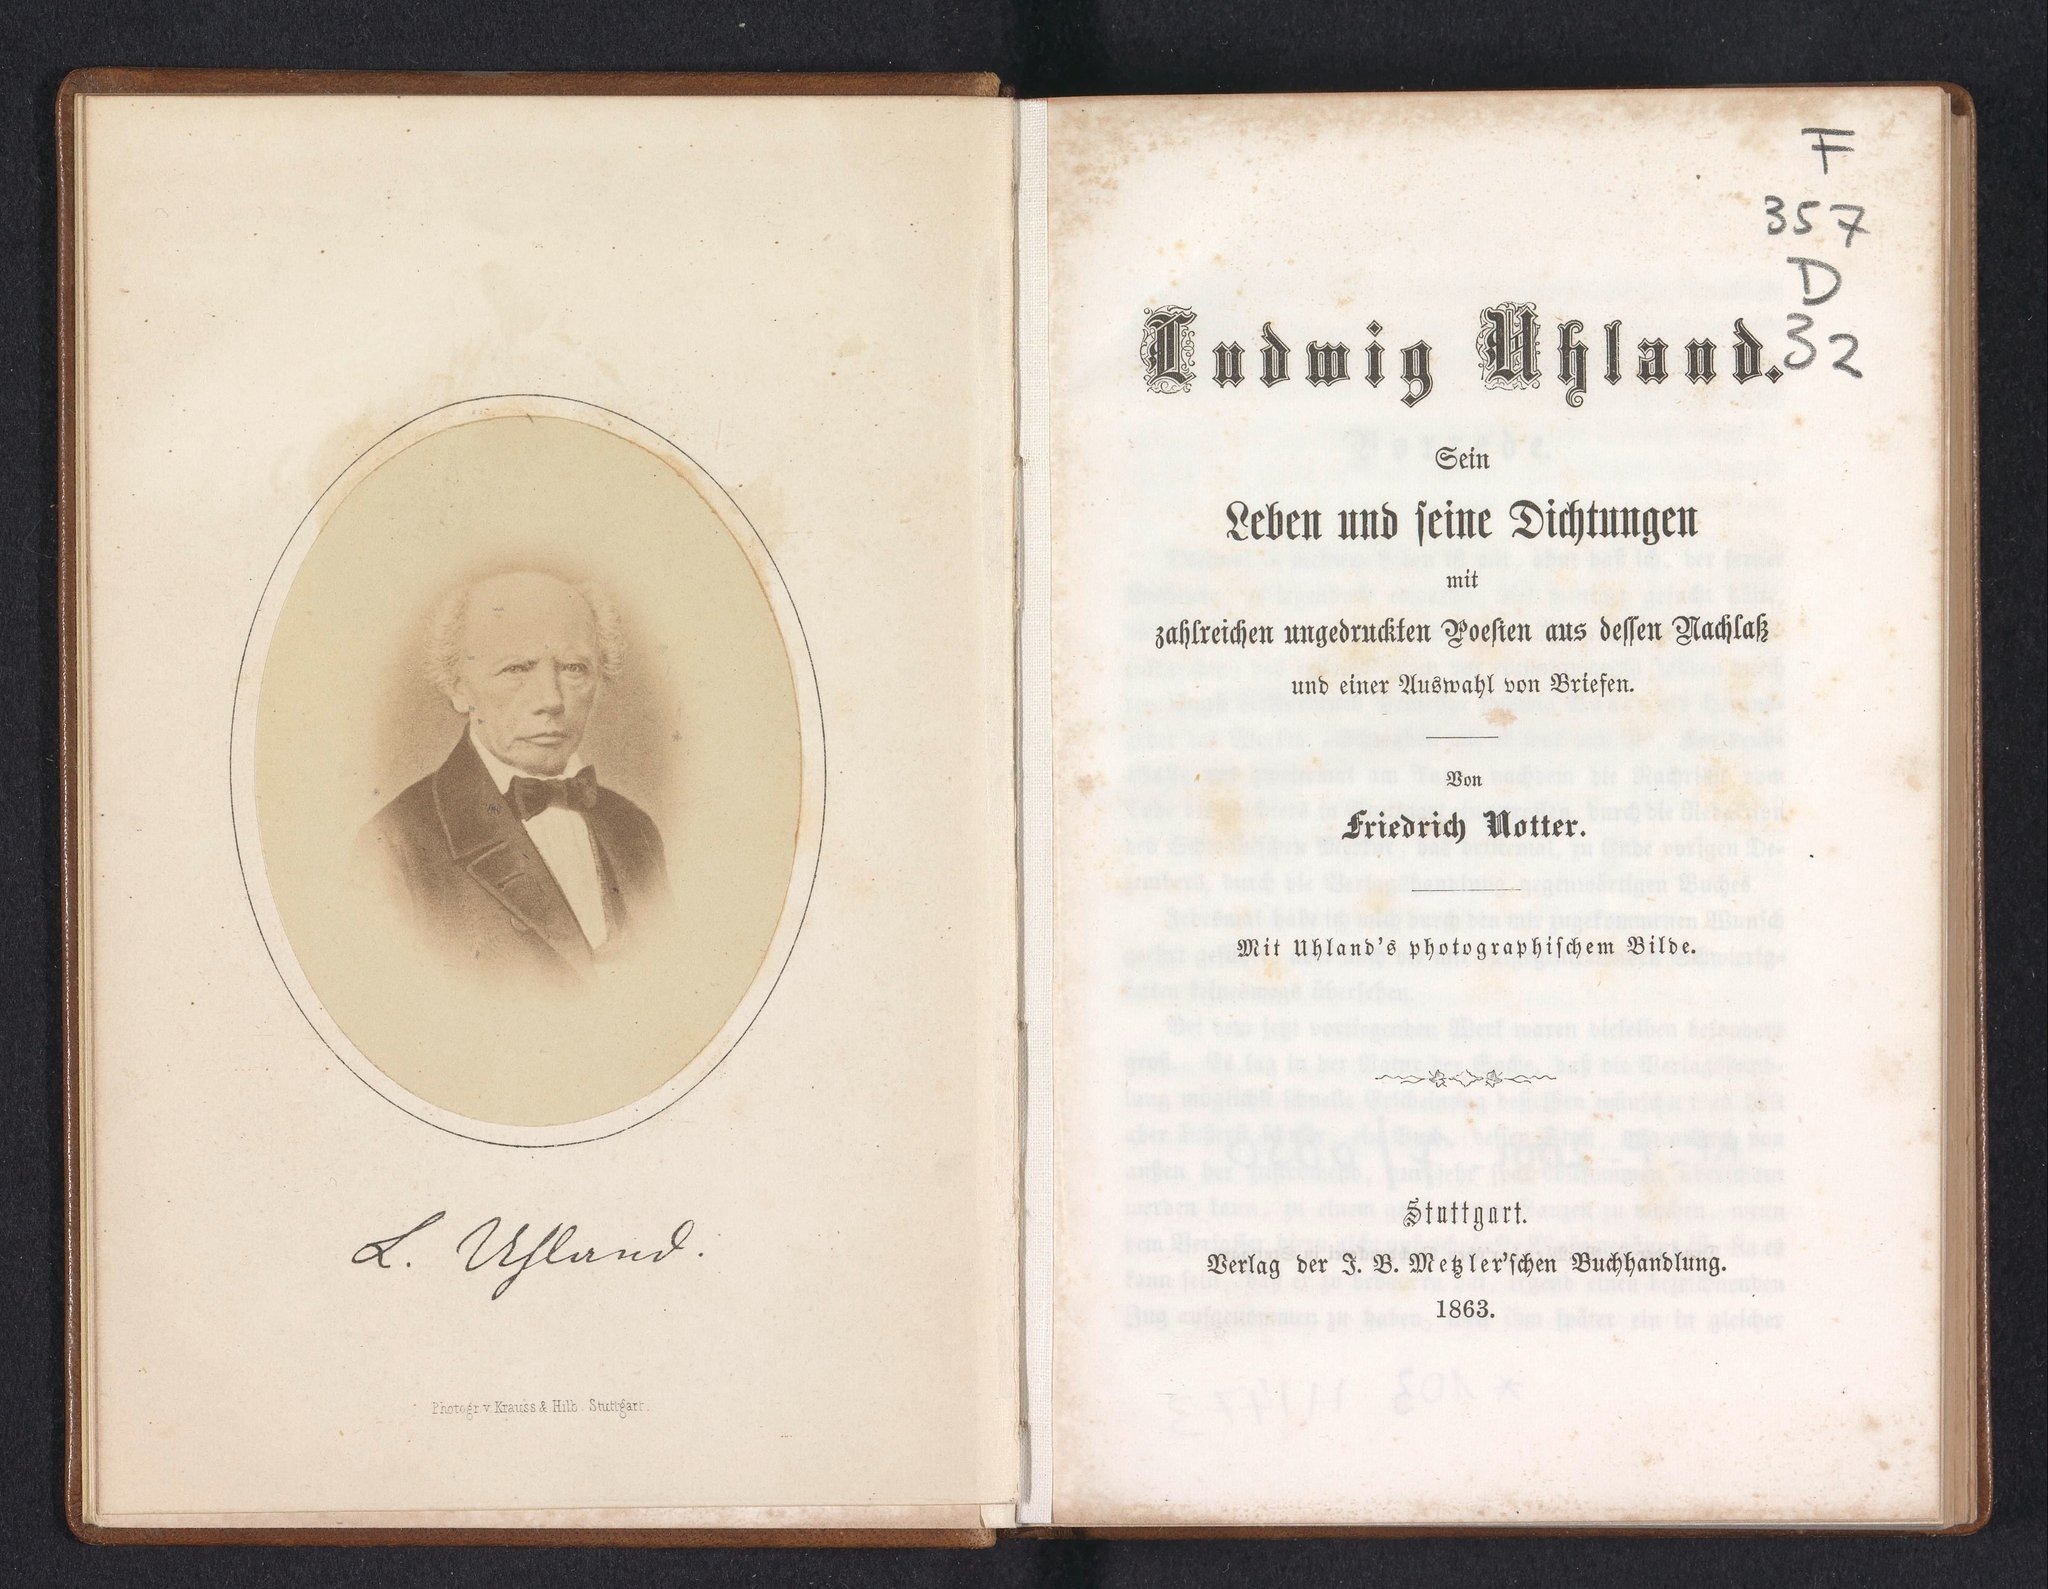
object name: book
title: Ludwig Uhland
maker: friedrich notter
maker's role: schrijver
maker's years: 1801-1884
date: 1863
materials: cardboard, leather, paper, photographic support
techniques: albumen print, printing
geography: stuttgart